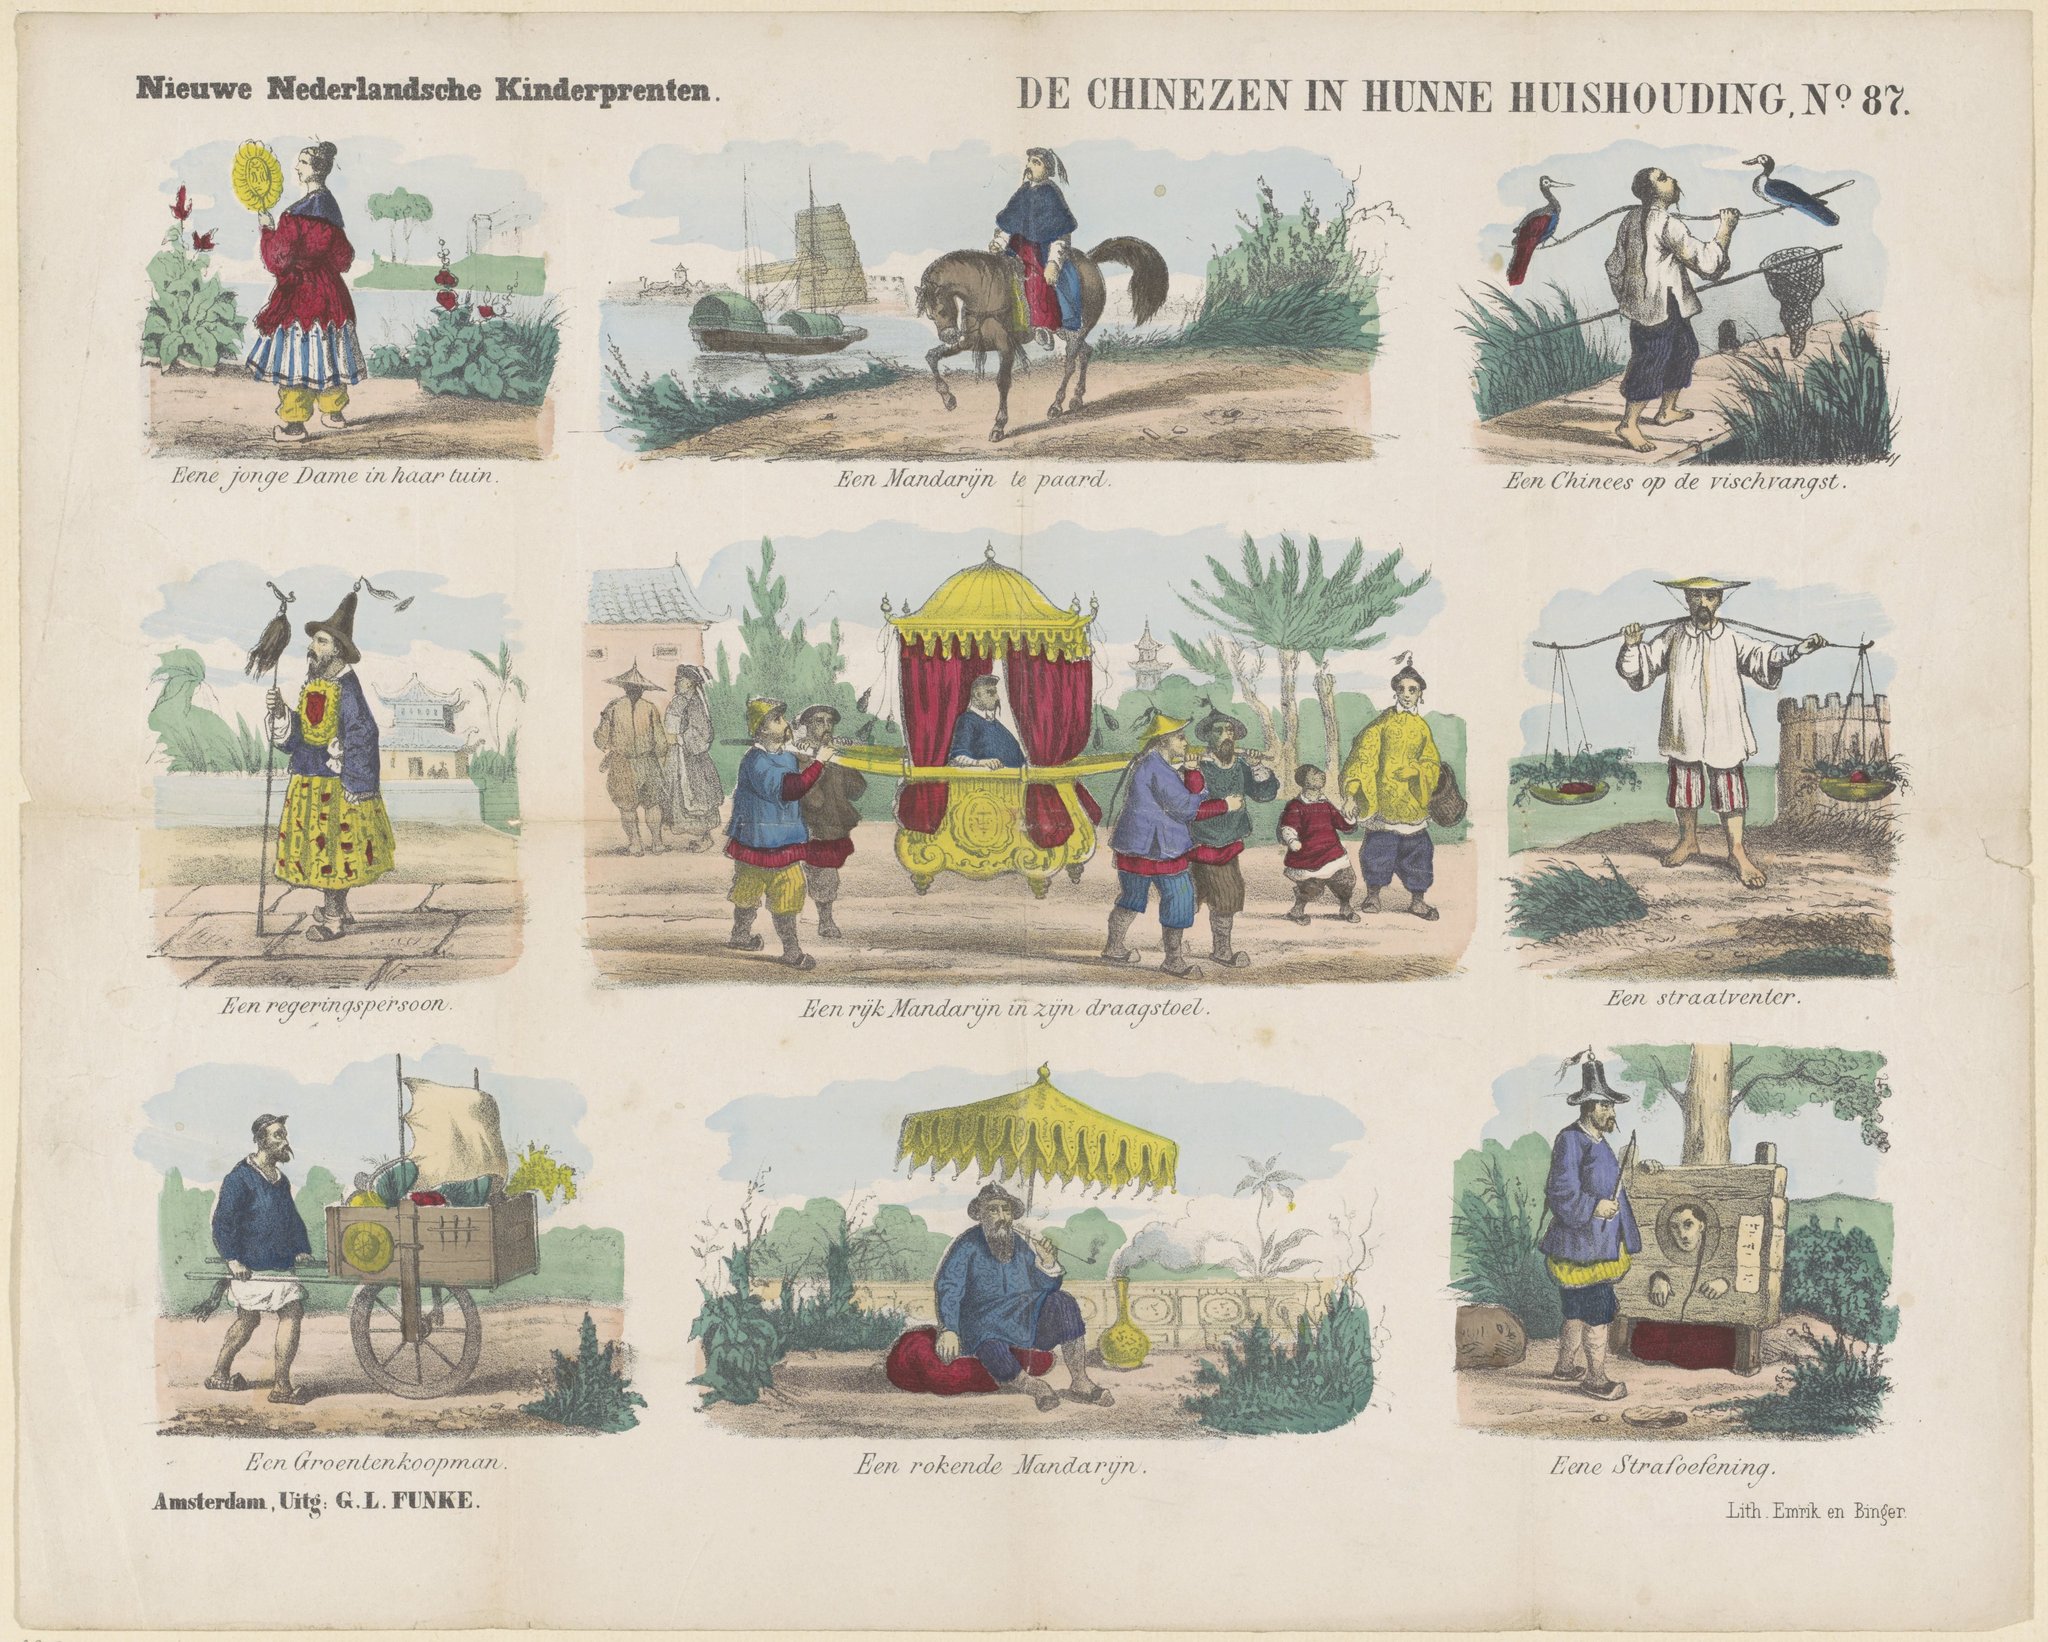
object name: popular print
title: Nieuwe Nederlandsche kinderprenten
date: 1865-1875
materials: paper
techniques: colour, letterpress printing, lithograph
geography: amsterdam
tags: chinese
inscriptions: collector's mark: Lugt 2760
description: Blad met 9 voorstellingen van Chinezen. Onder elke afbeelding een onderschrift. Genummerd rechtsboven: No. 87.